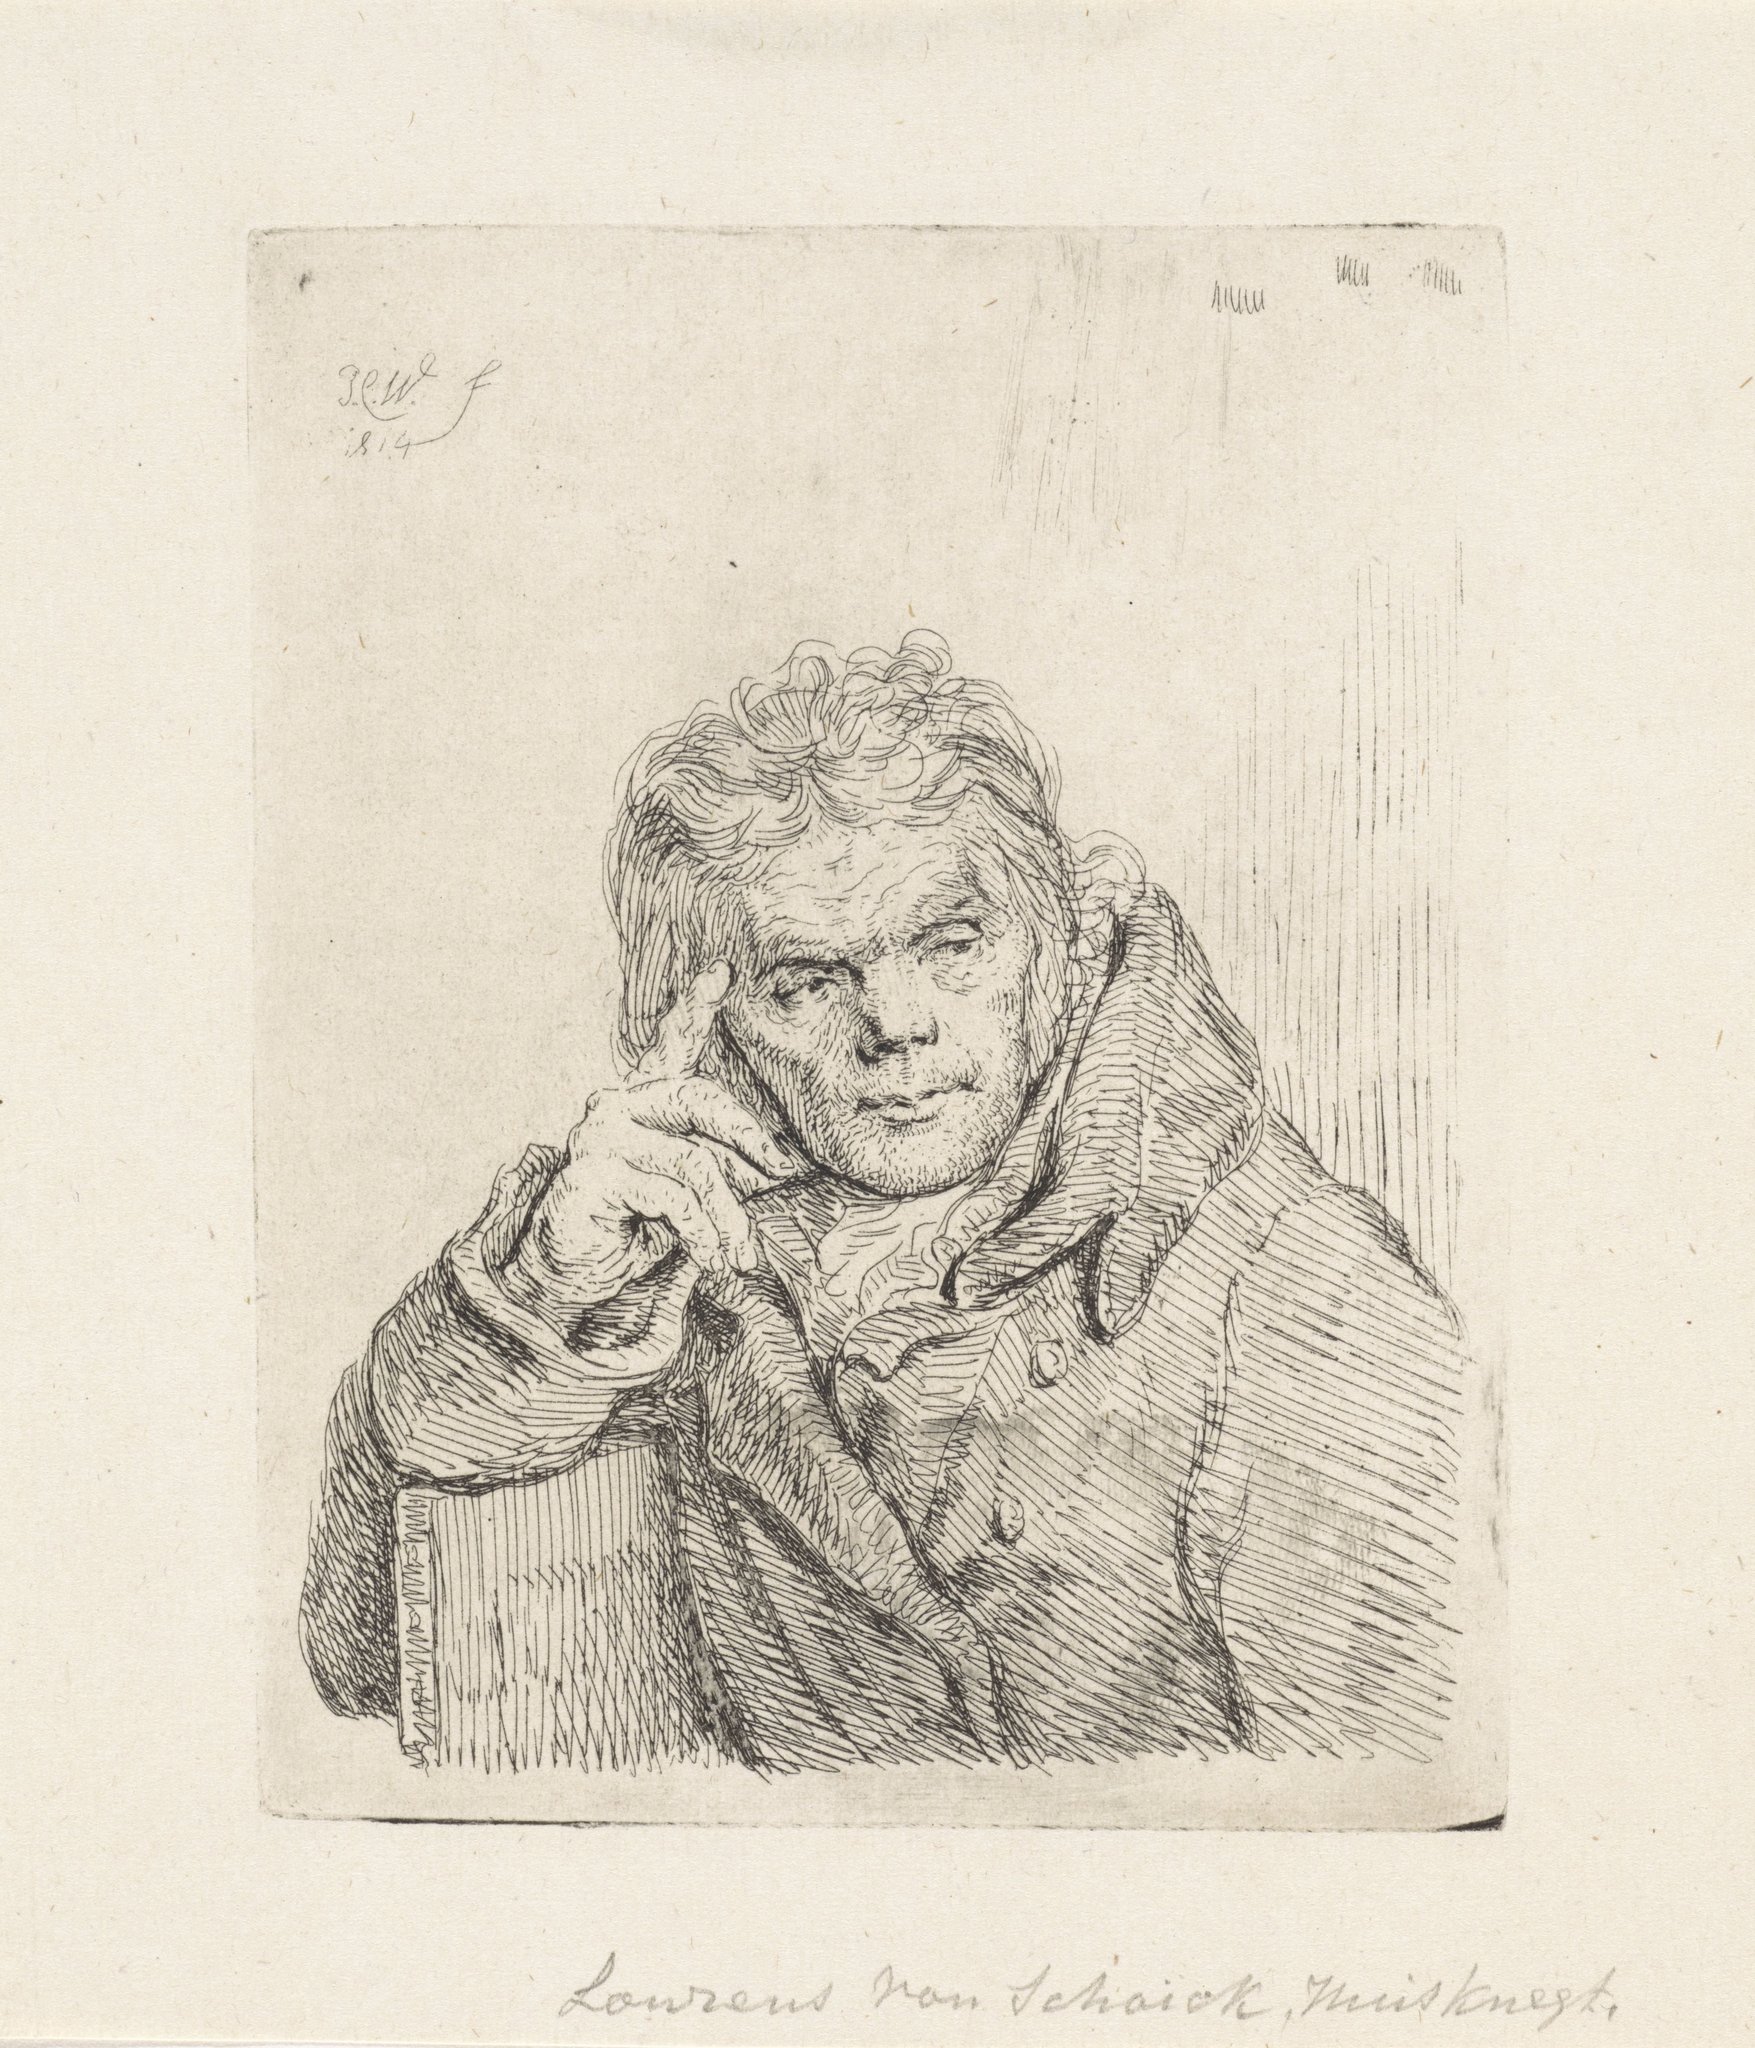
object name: print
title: Portret van Laurens van Schaik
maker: pieter christoffel wonder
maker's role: draughtsman, painter, print maker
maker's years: 1780-1852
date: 1814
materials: paper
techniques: etching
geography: utrecht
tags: historical persons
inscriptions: collector's mark: Lugt 2228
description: Portret van Laurens van Schaik. Zijn arm rust op de leuning van een stoel en met zijn hand ondersteunt hij zijn hoofd. Van Schaik was de bediende van de kunstenaar en zijn ouders.